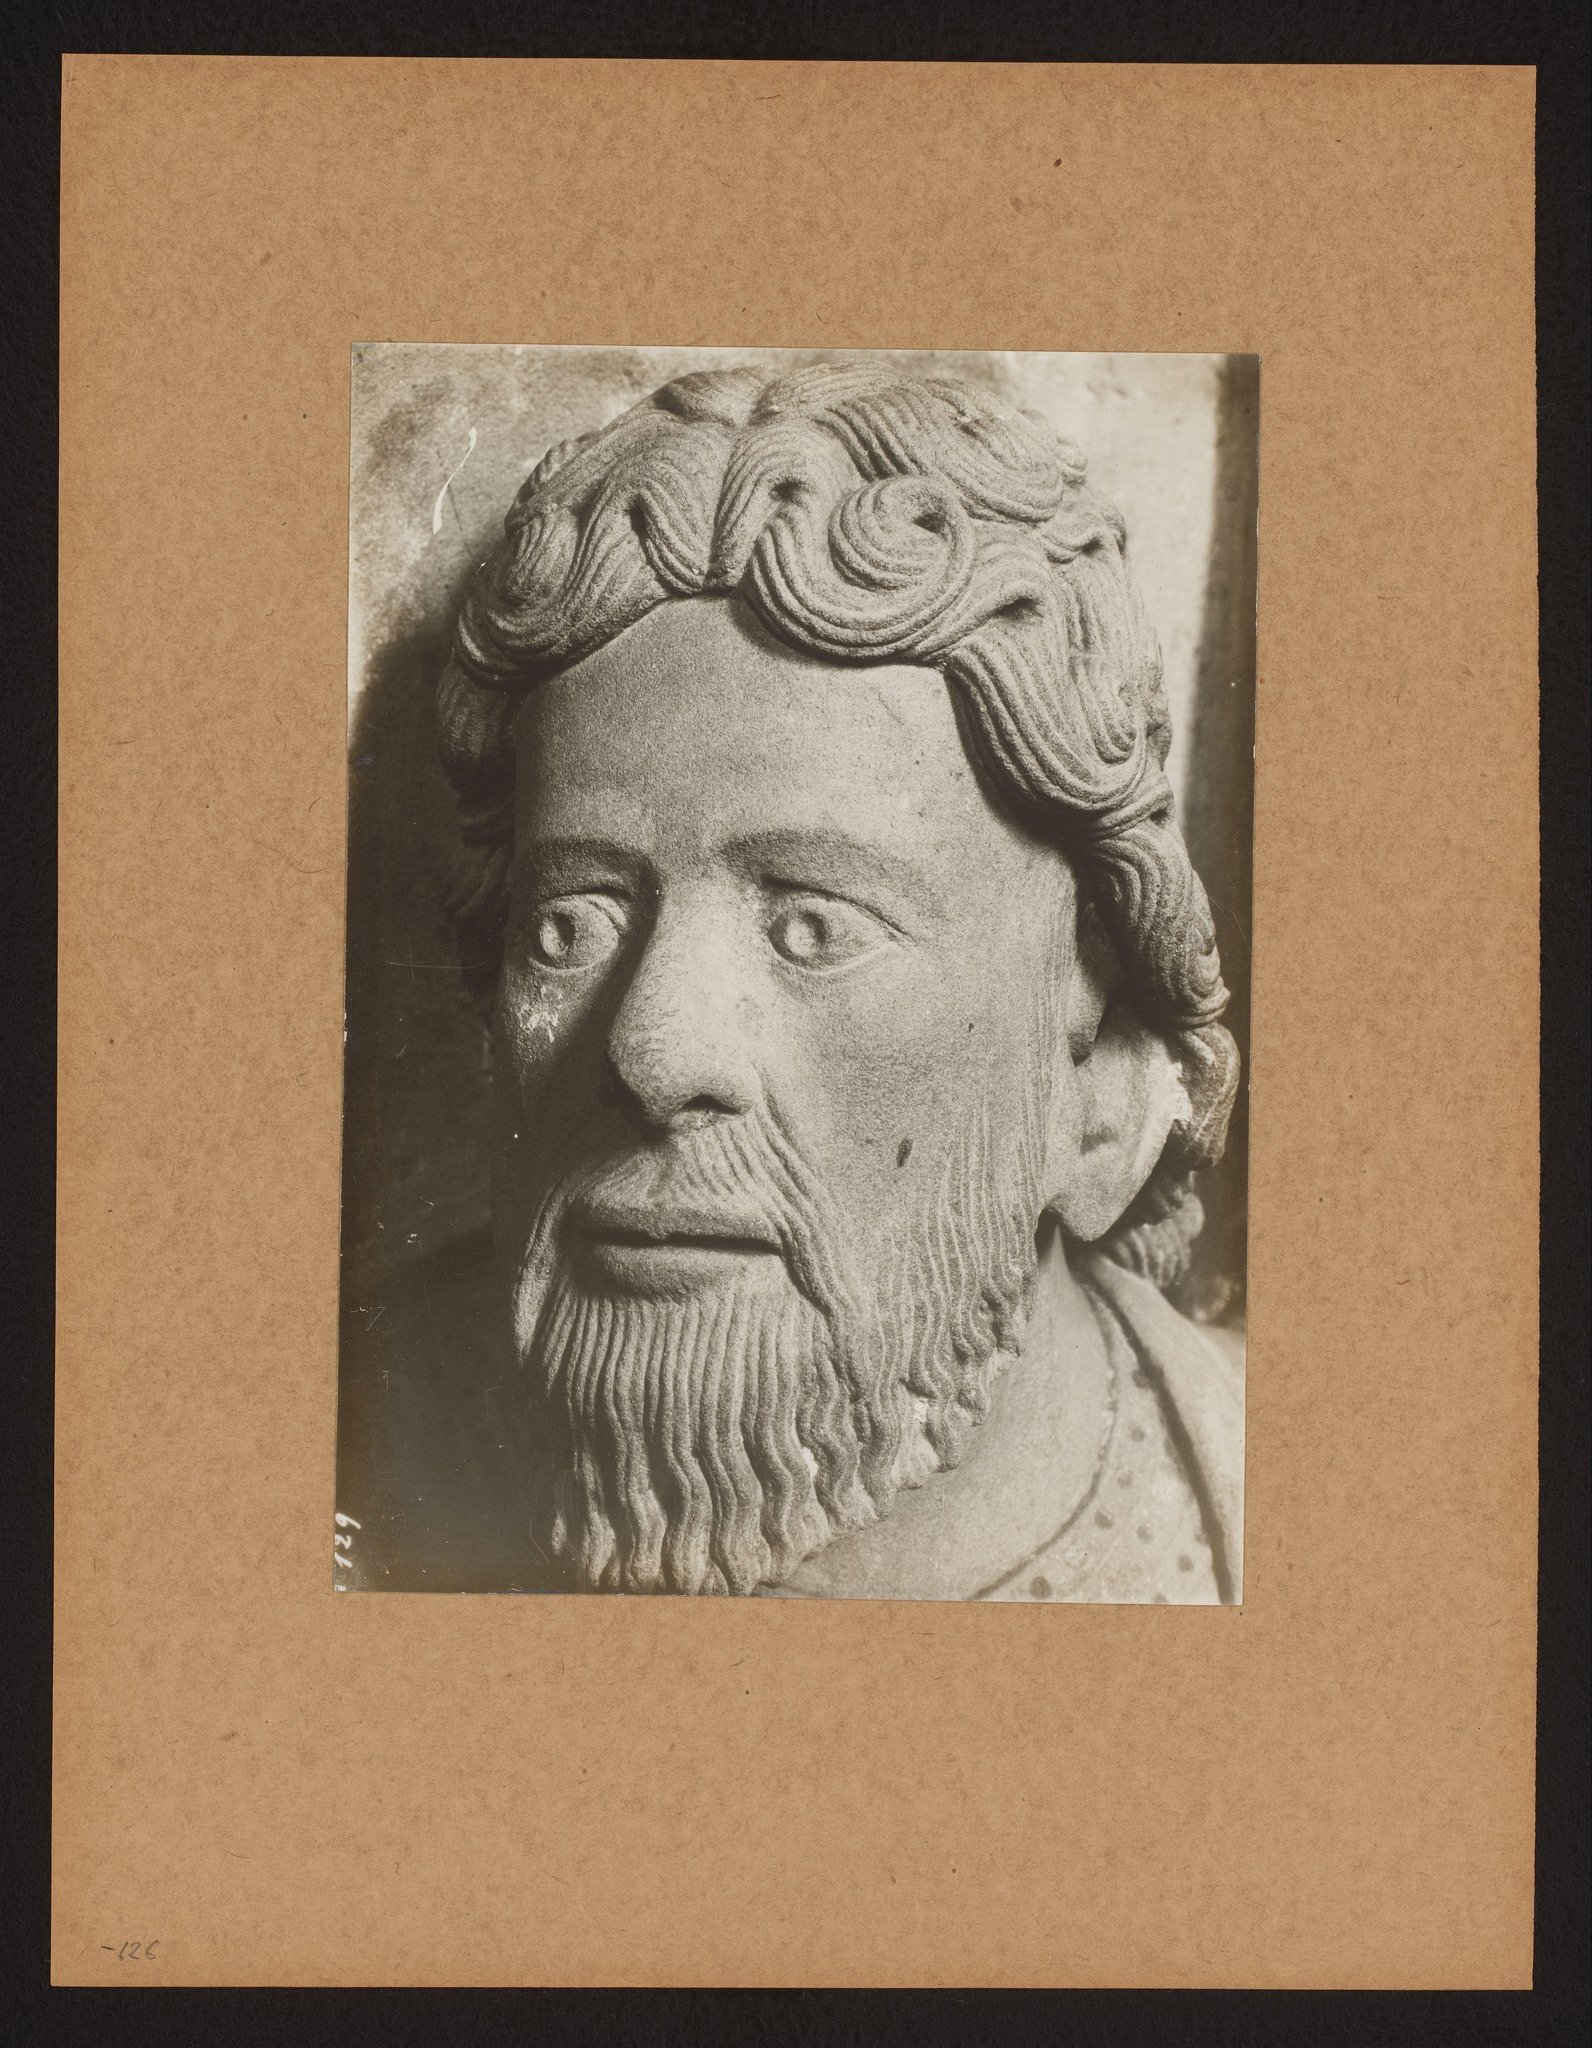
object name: photograph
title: Detail van het doksaal in het Ostchor van de dom van Bamberg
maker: Anonymous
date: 1900-1920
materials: paper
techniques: gelatin silver print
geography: bamberg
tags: interior of church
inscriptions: number: ‘129’